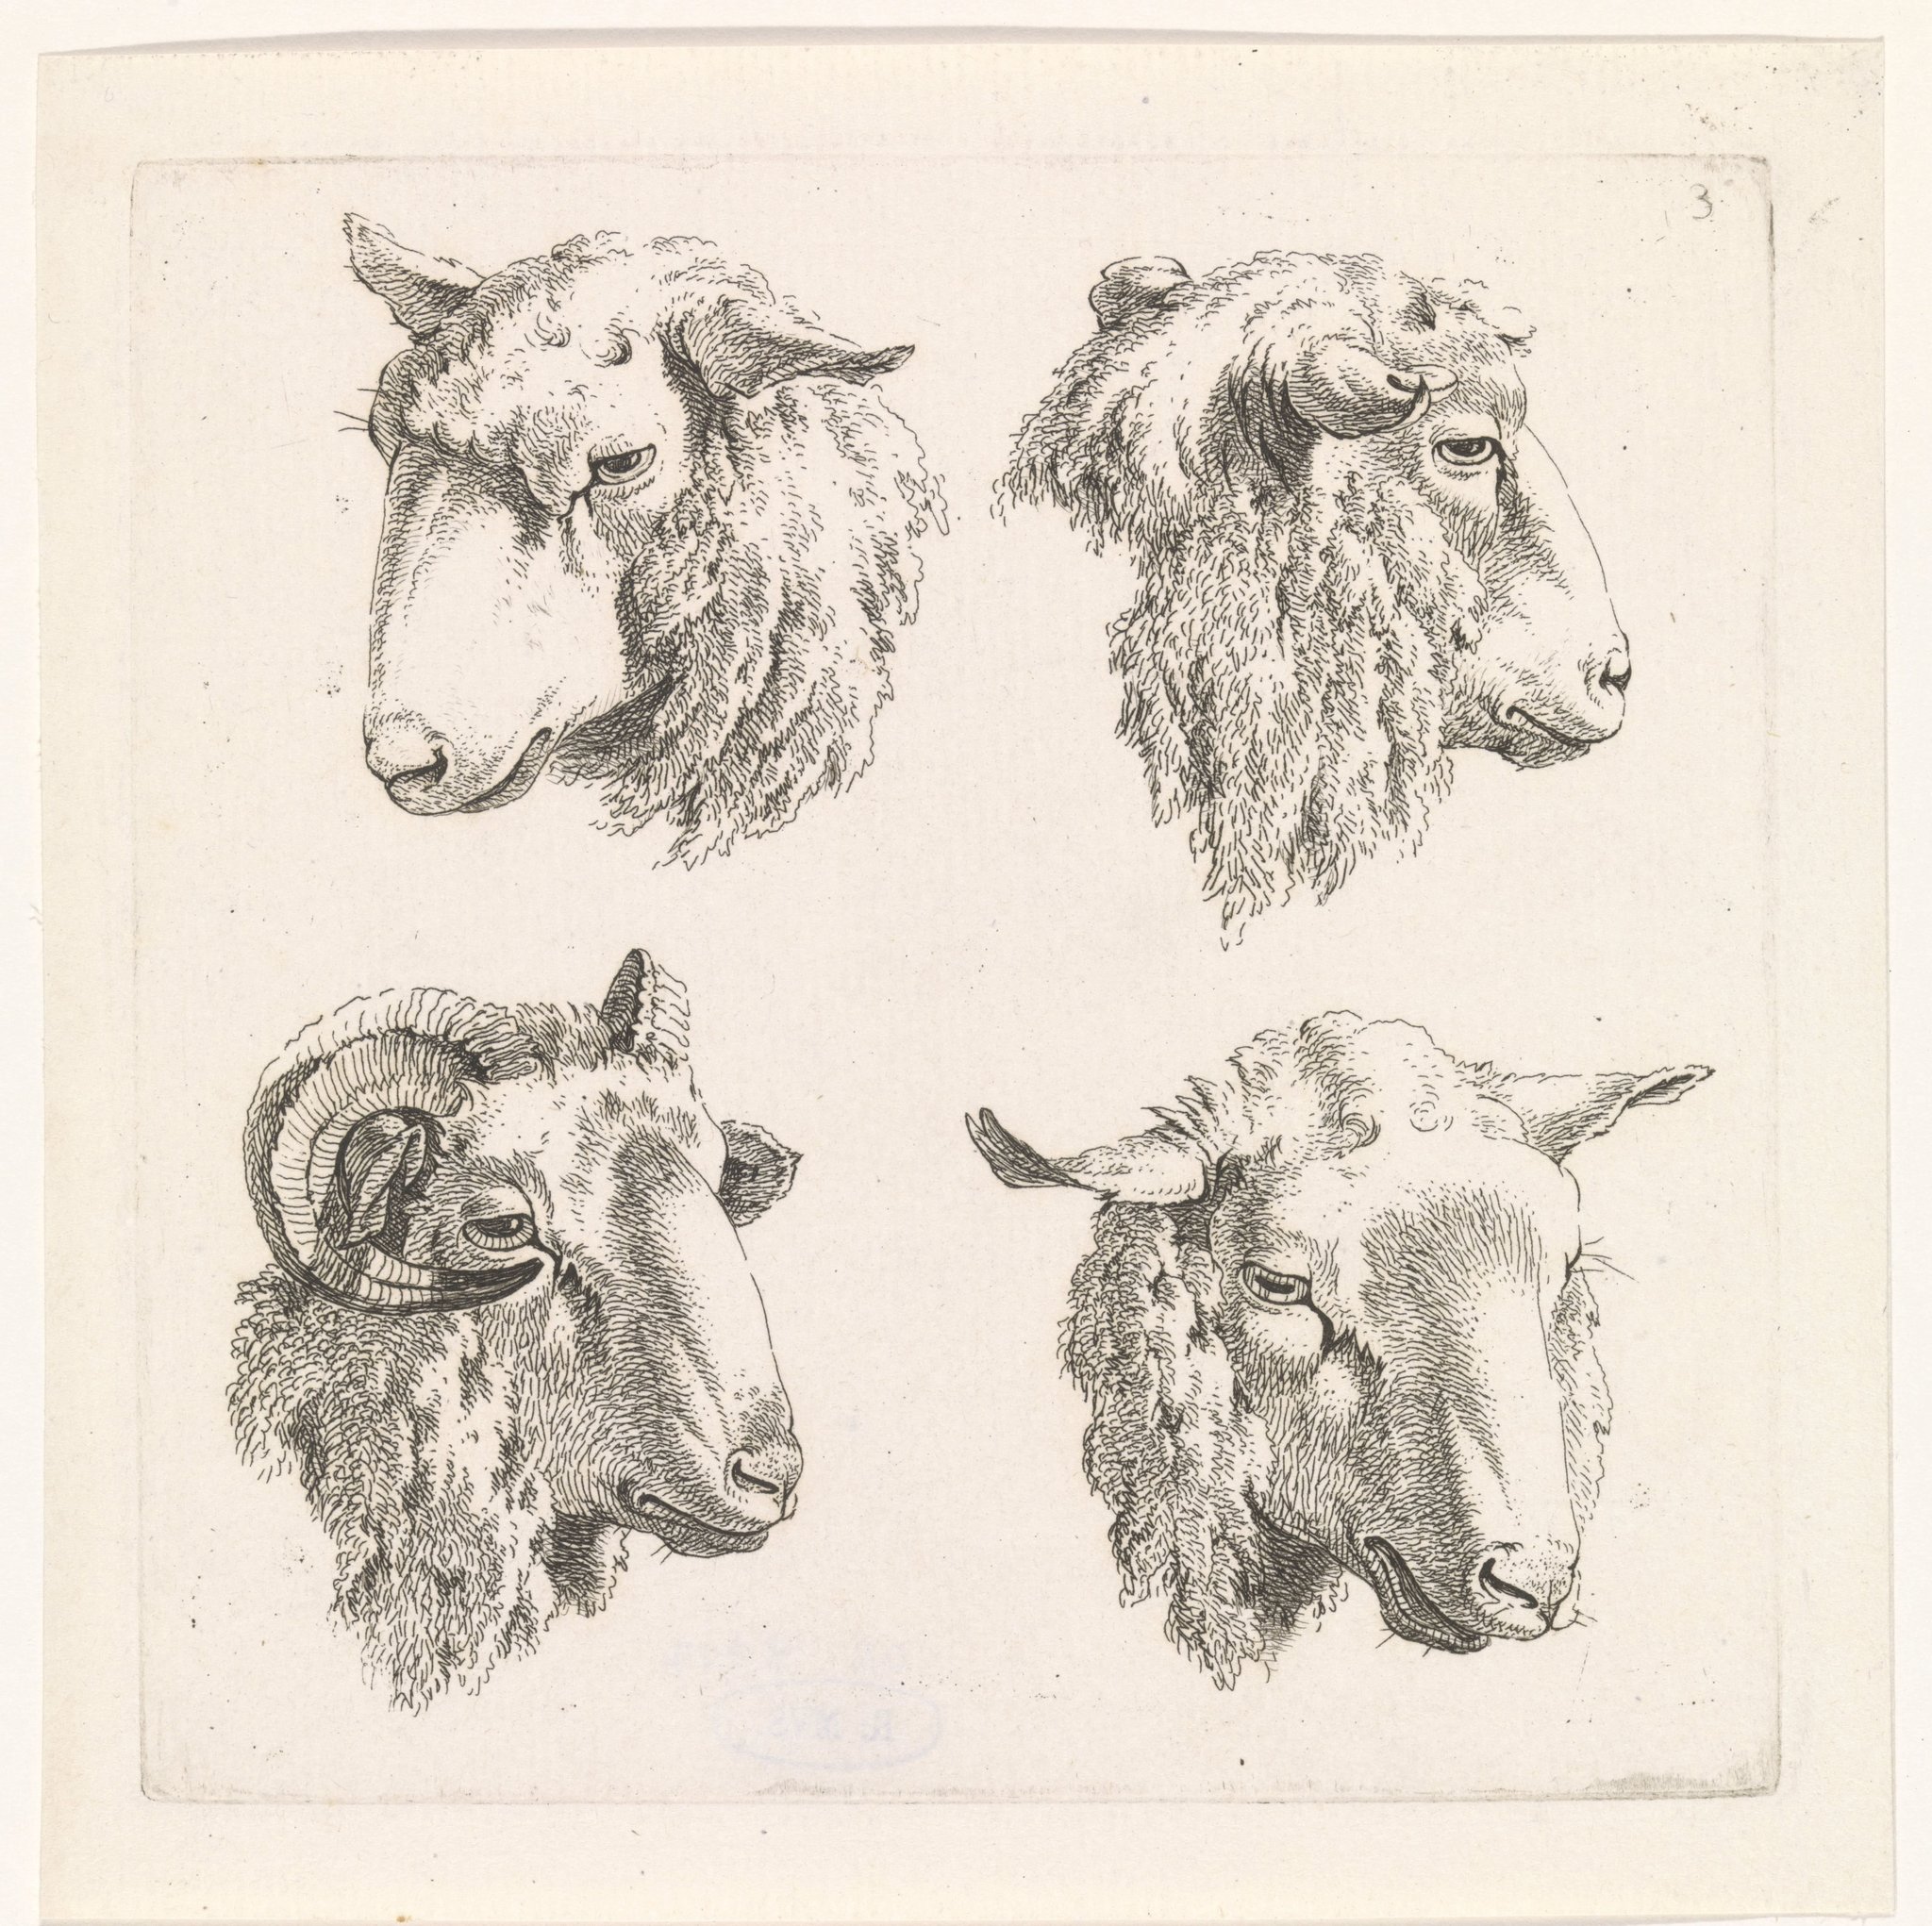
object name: print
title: Vier schaapskoppen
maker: barend hendrik thier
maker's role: draughtsman, print maker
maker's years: 1743-1811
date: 1755-1811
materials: paper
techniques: etching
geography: netherlands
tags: sheep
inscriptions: collector's mark: Lugt 2228